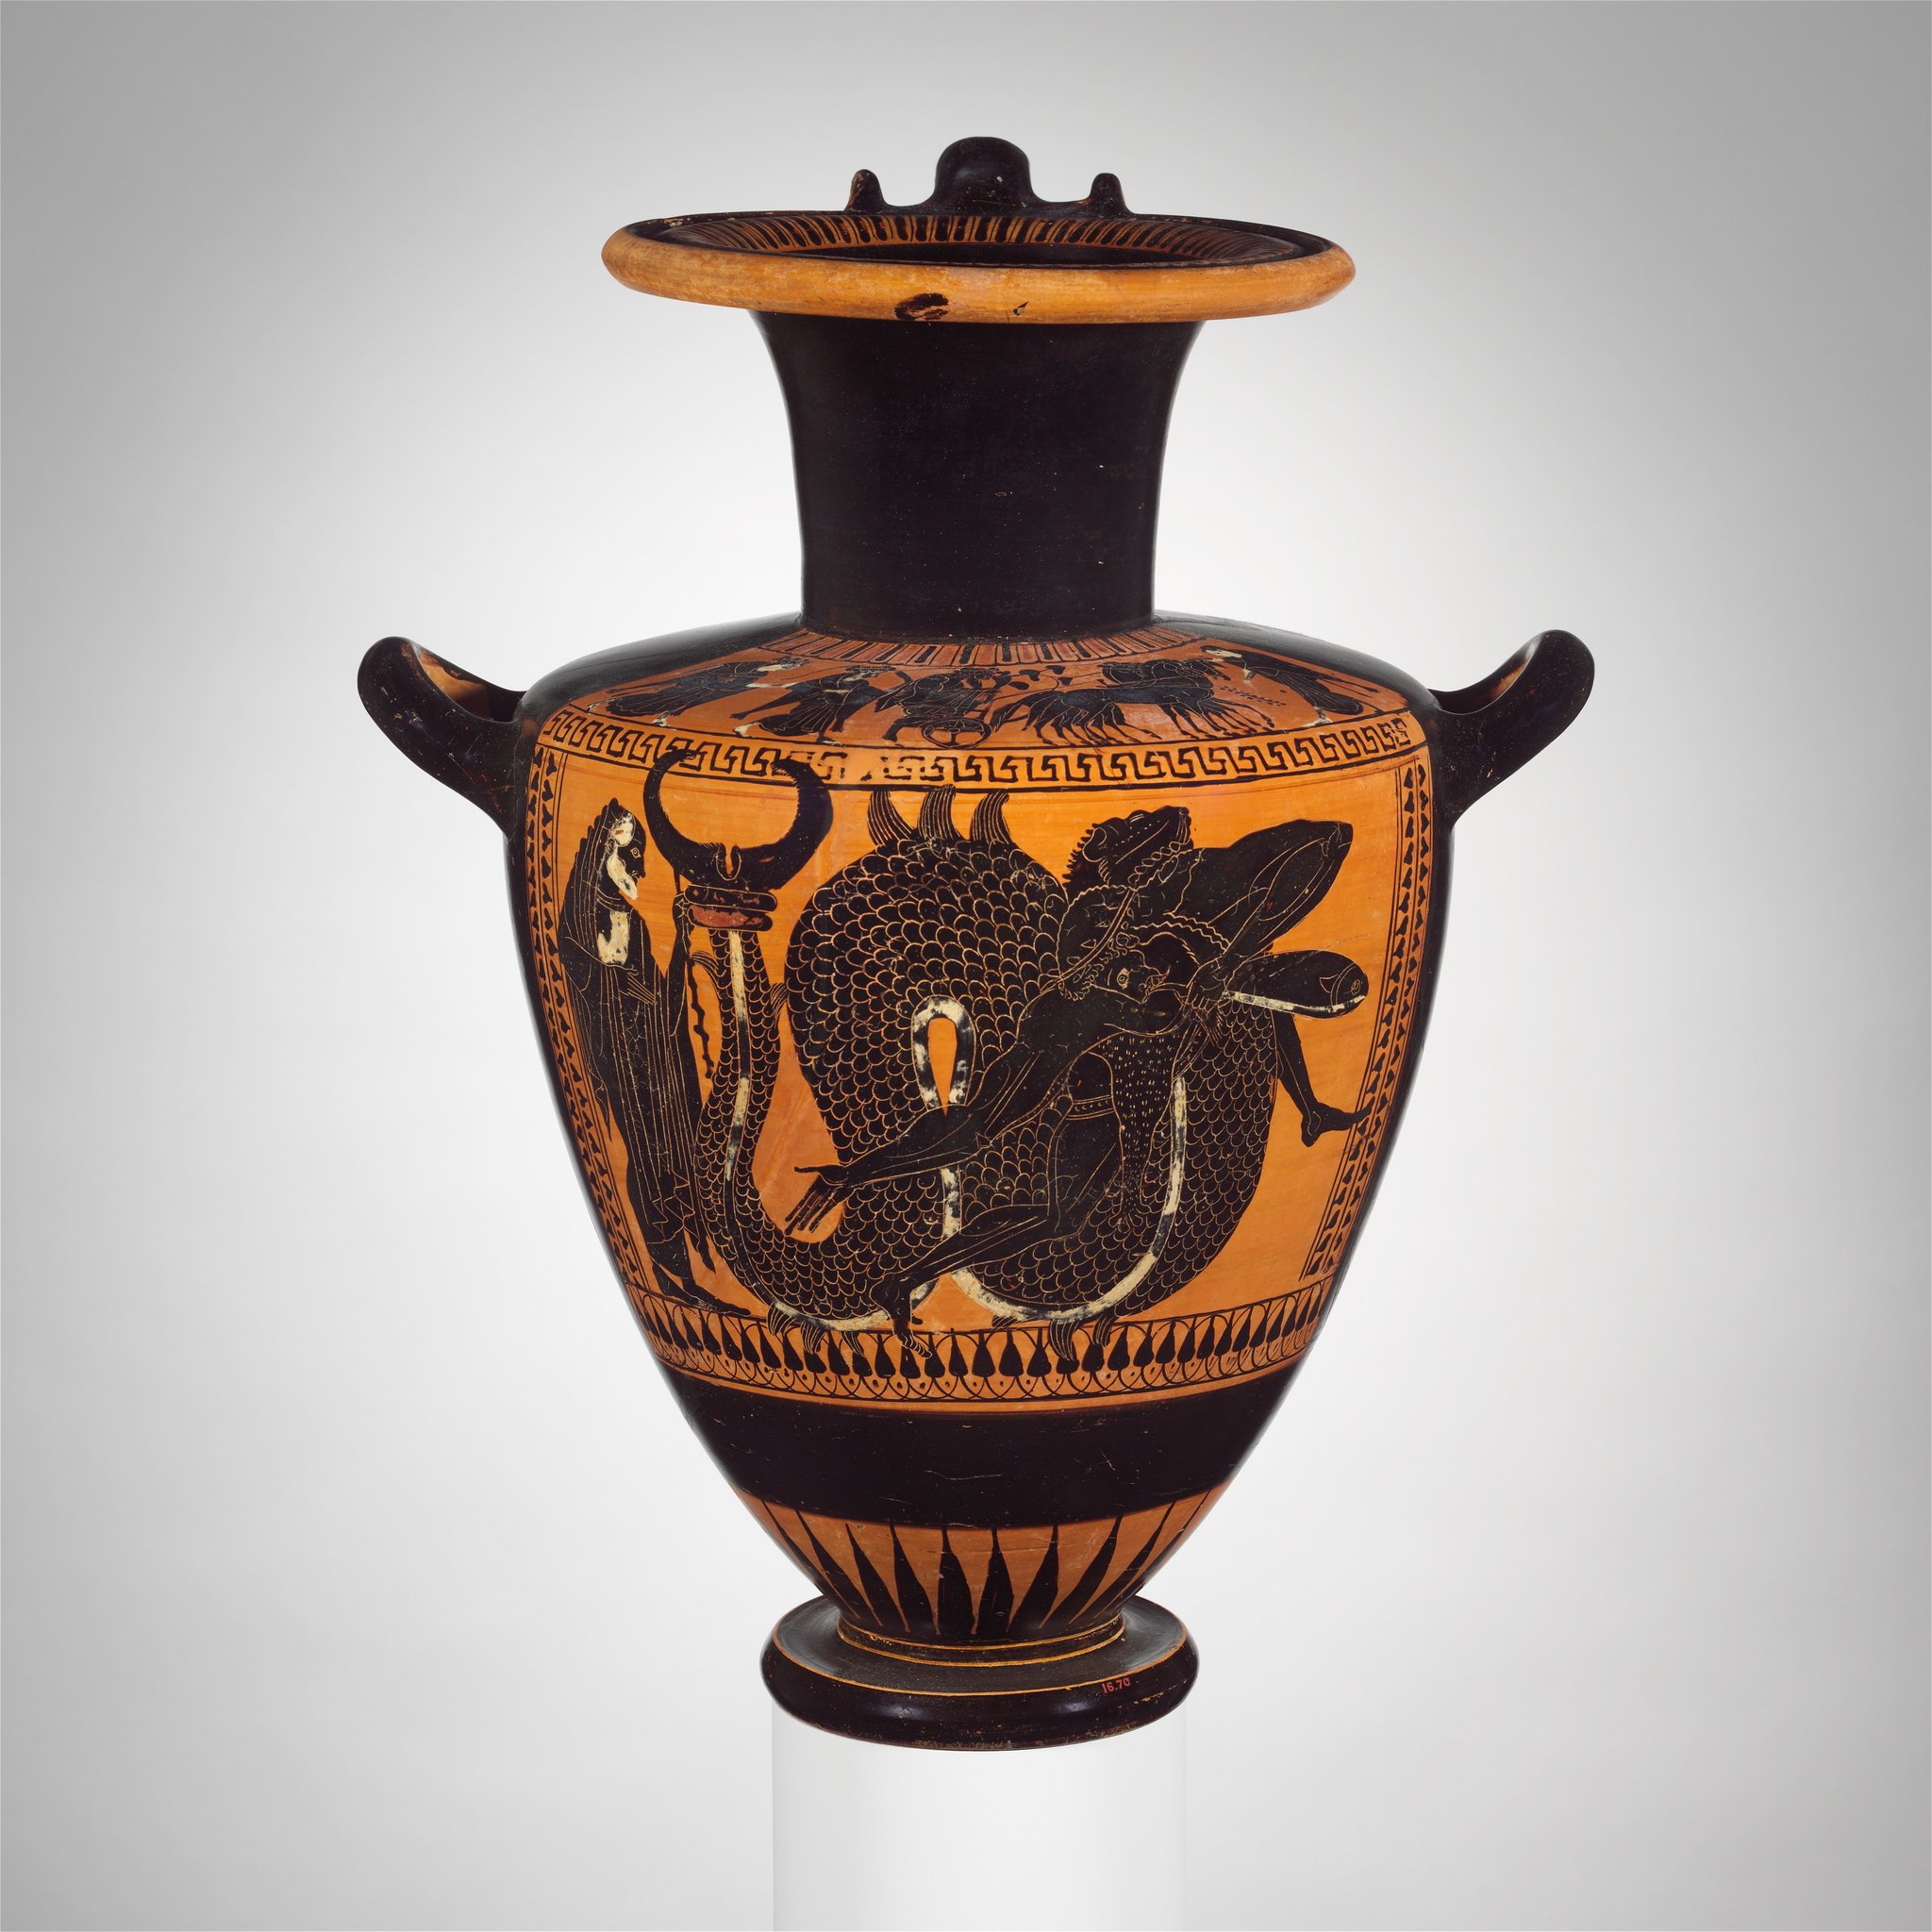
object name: hydria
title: Terracotta hydria (water jar)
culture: greek, attic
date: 520-510 BCE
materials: terracotta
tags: triton,maenads,chariots